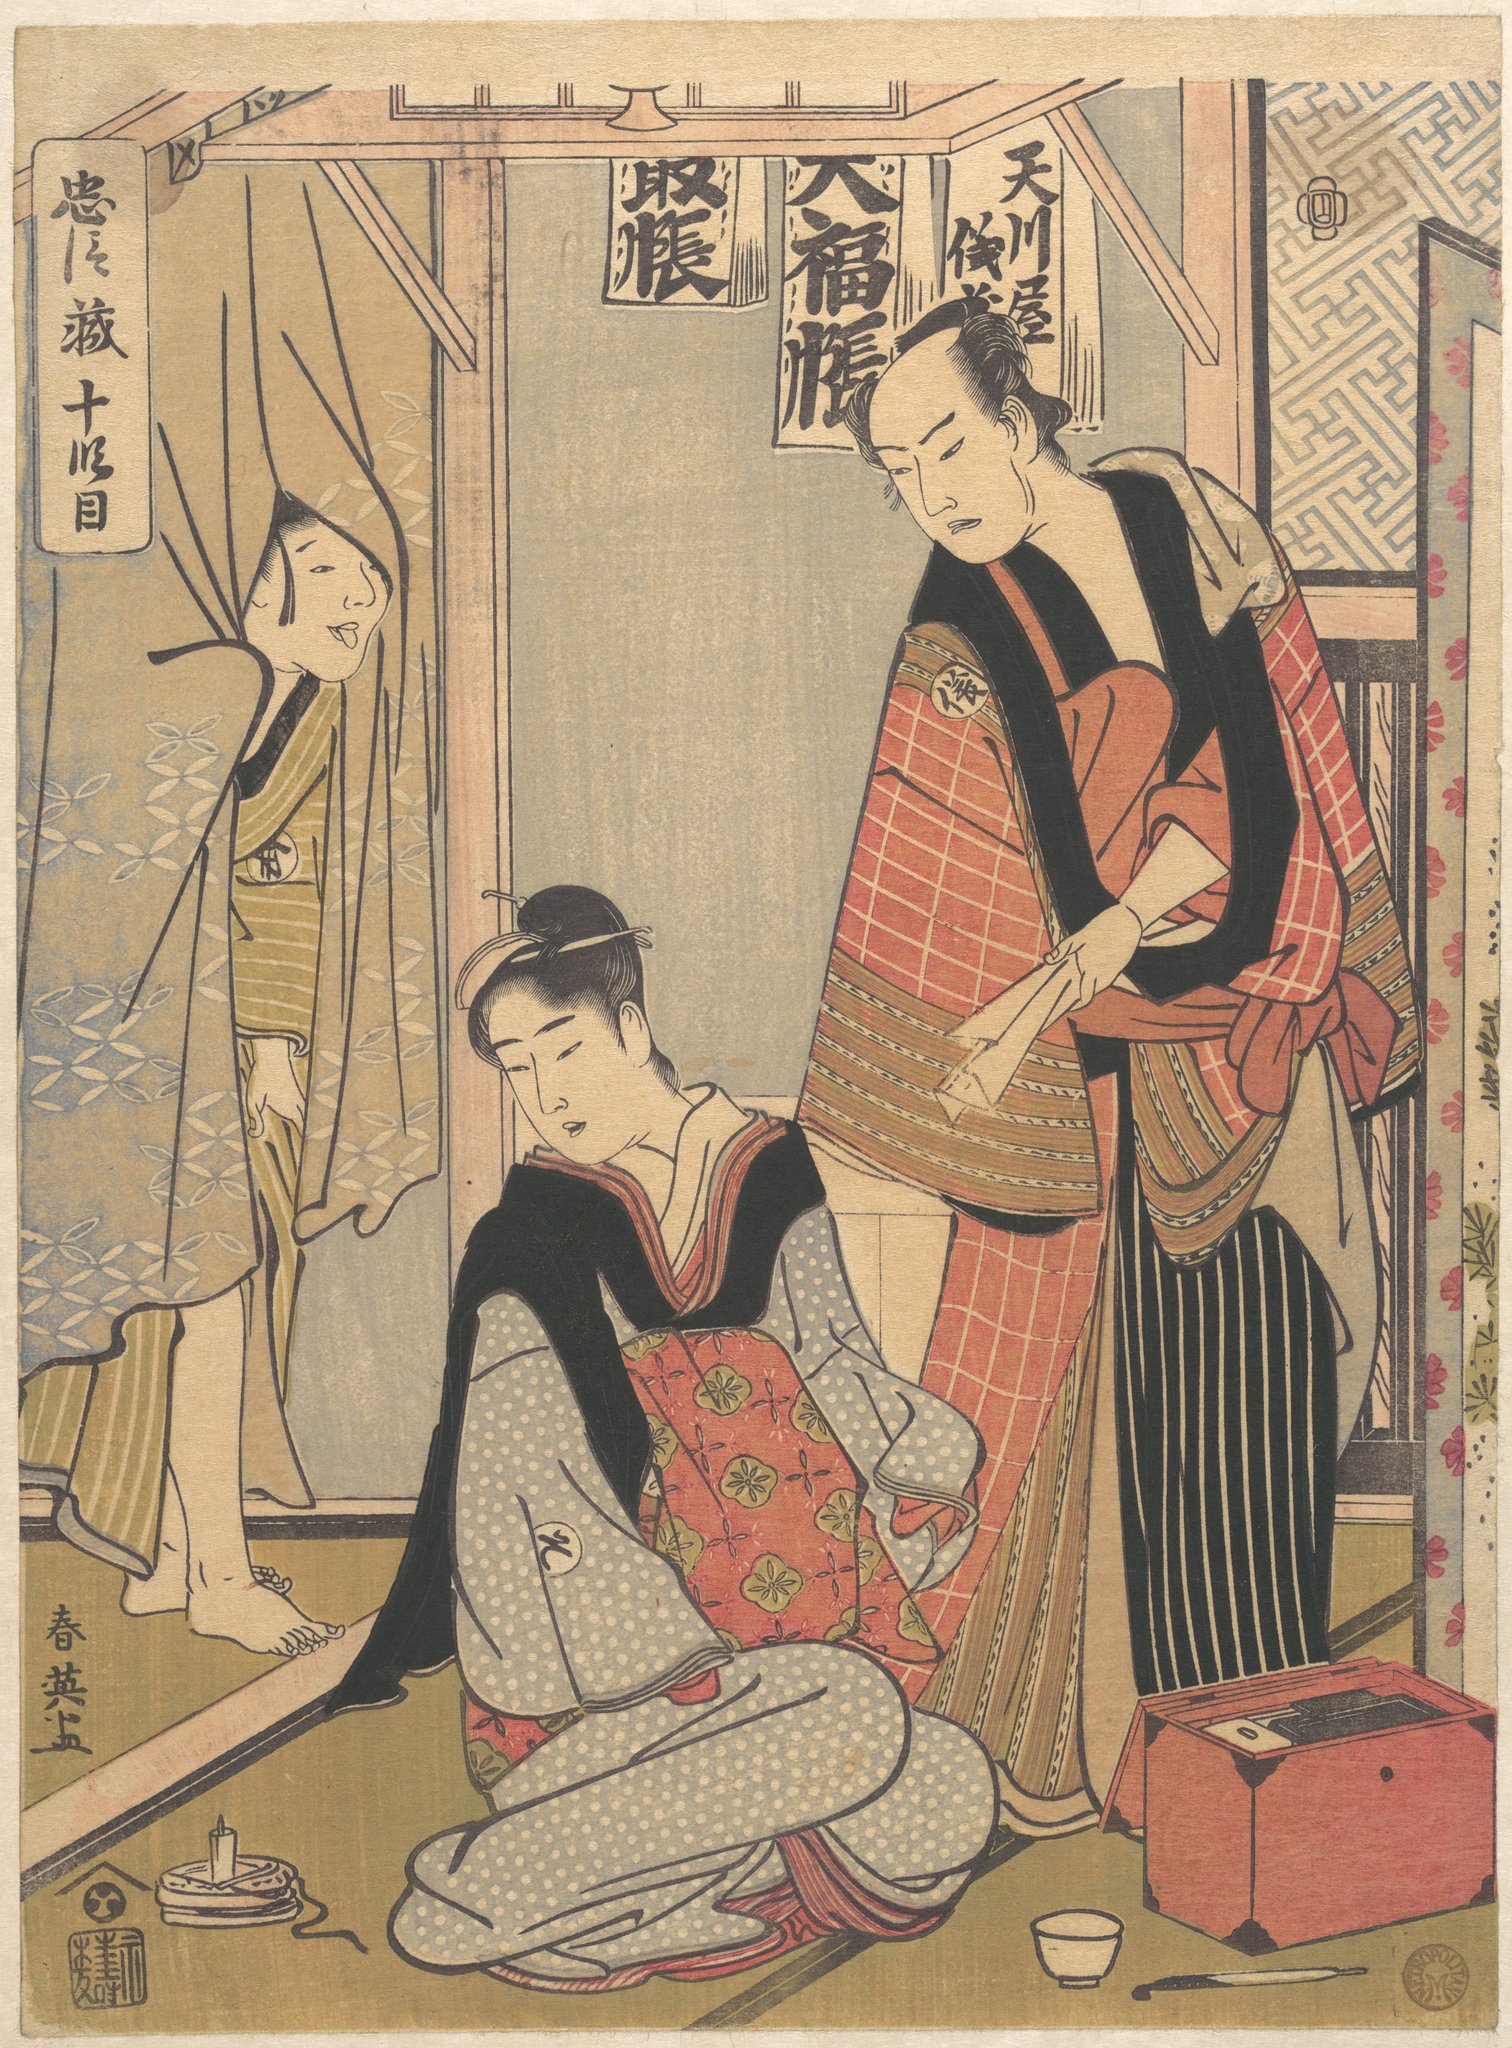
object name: print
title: Scene from the Tenth Act of Chushingura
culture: japanese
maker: katsukawa shun'ei 勝川春英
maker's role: artist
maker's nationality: japanese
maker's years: 1762-1819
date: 1790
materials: ink, paper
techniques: woodblock print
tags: men,women,actors